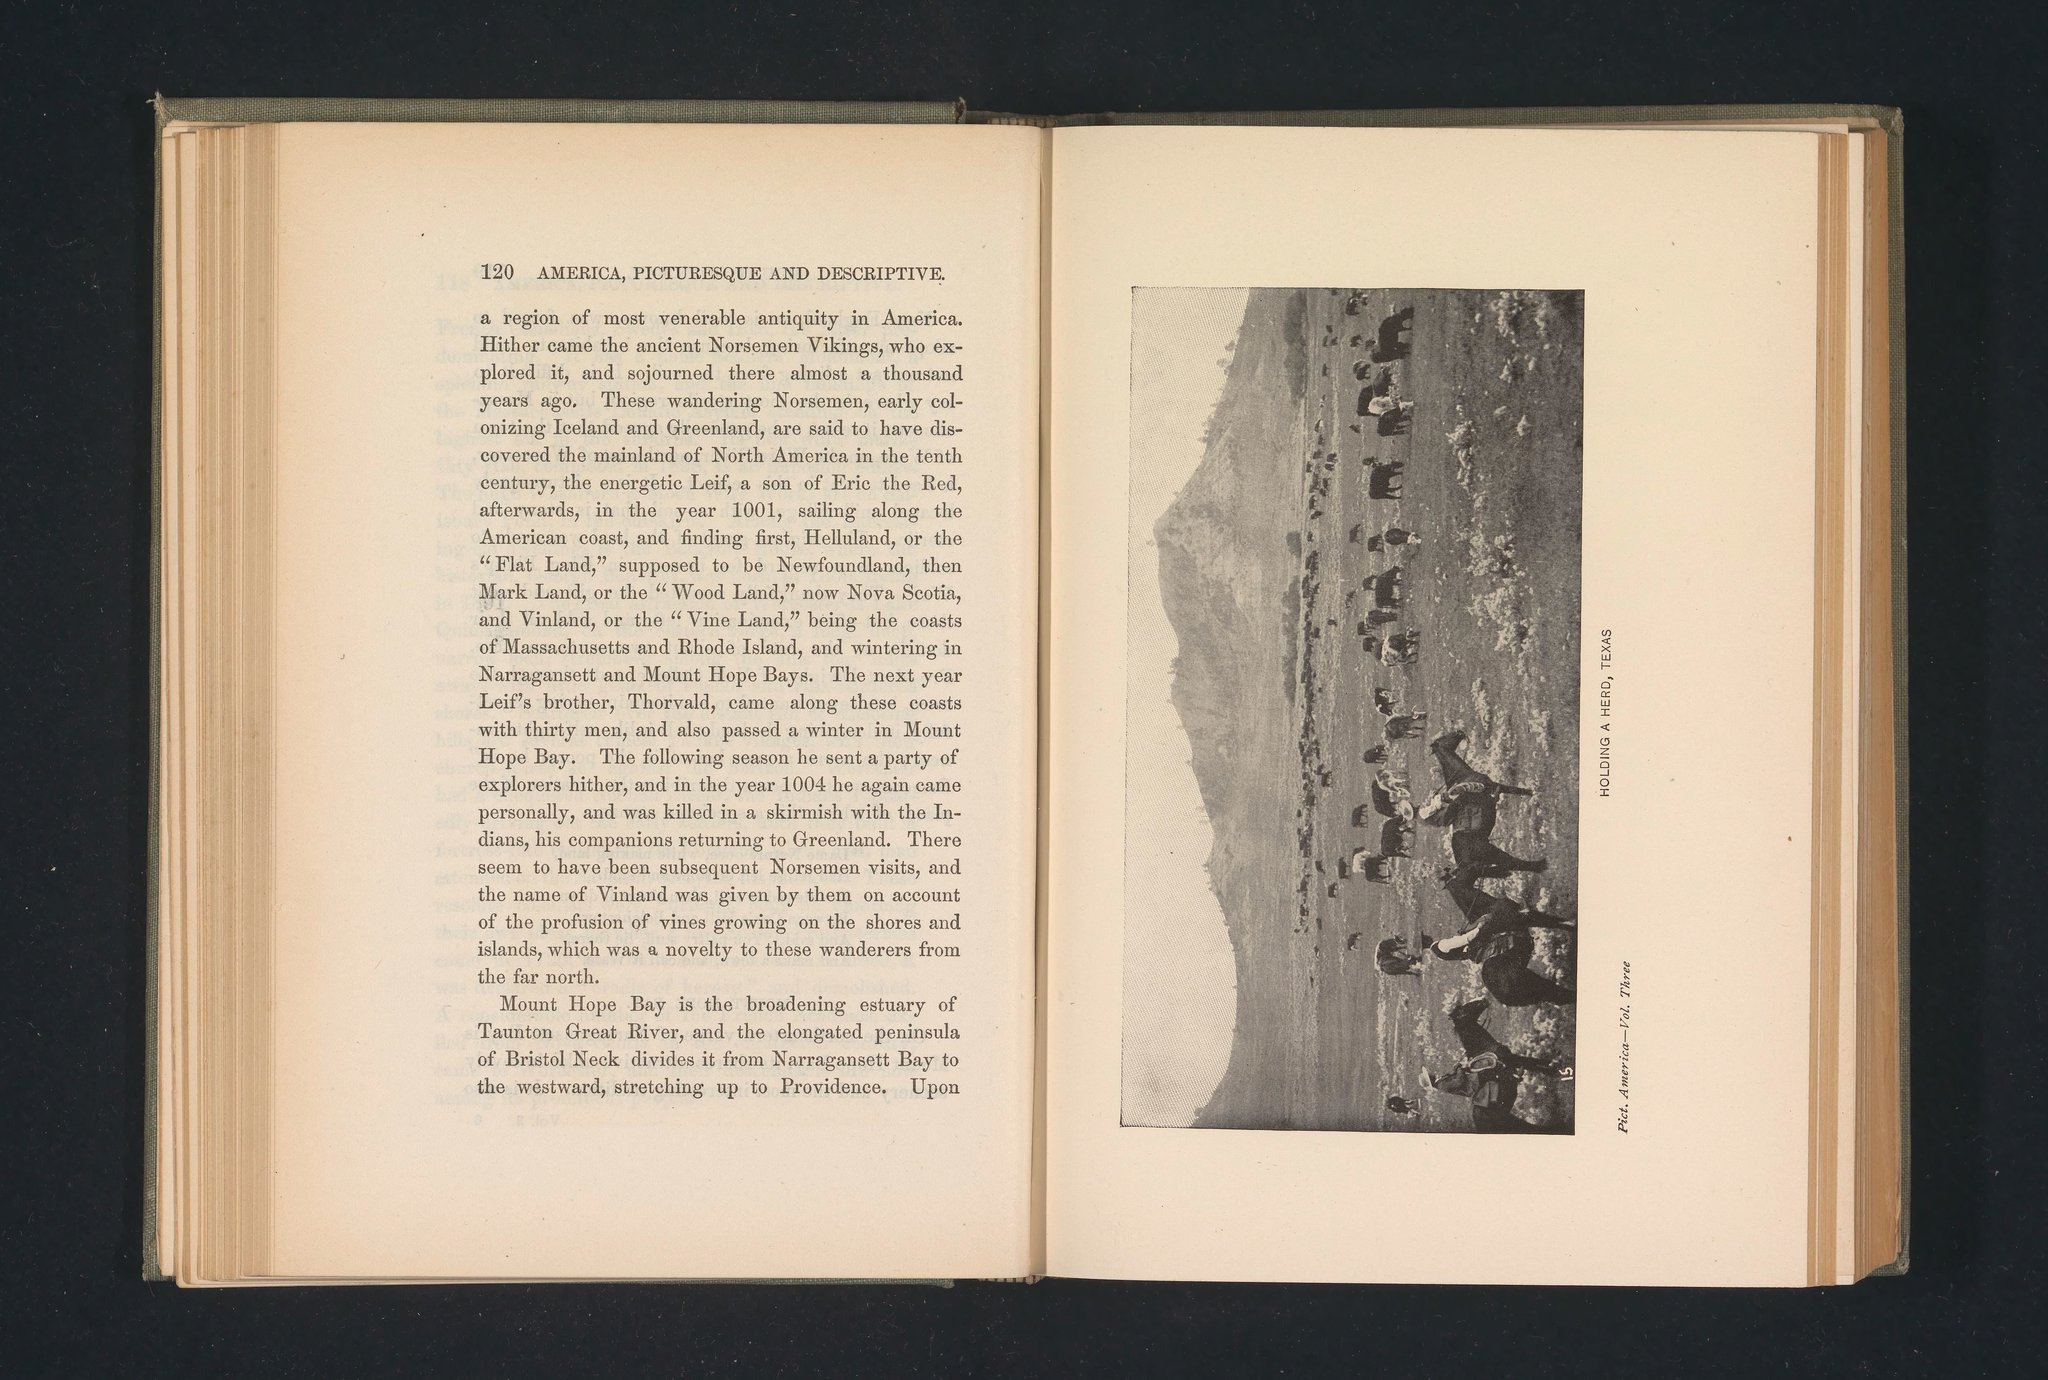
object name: page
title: Holding a herd, Texas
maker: Anonymous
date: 1890-1900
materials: paper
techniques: autotype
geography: texas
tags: cowboy, cattle driving, cattle driver